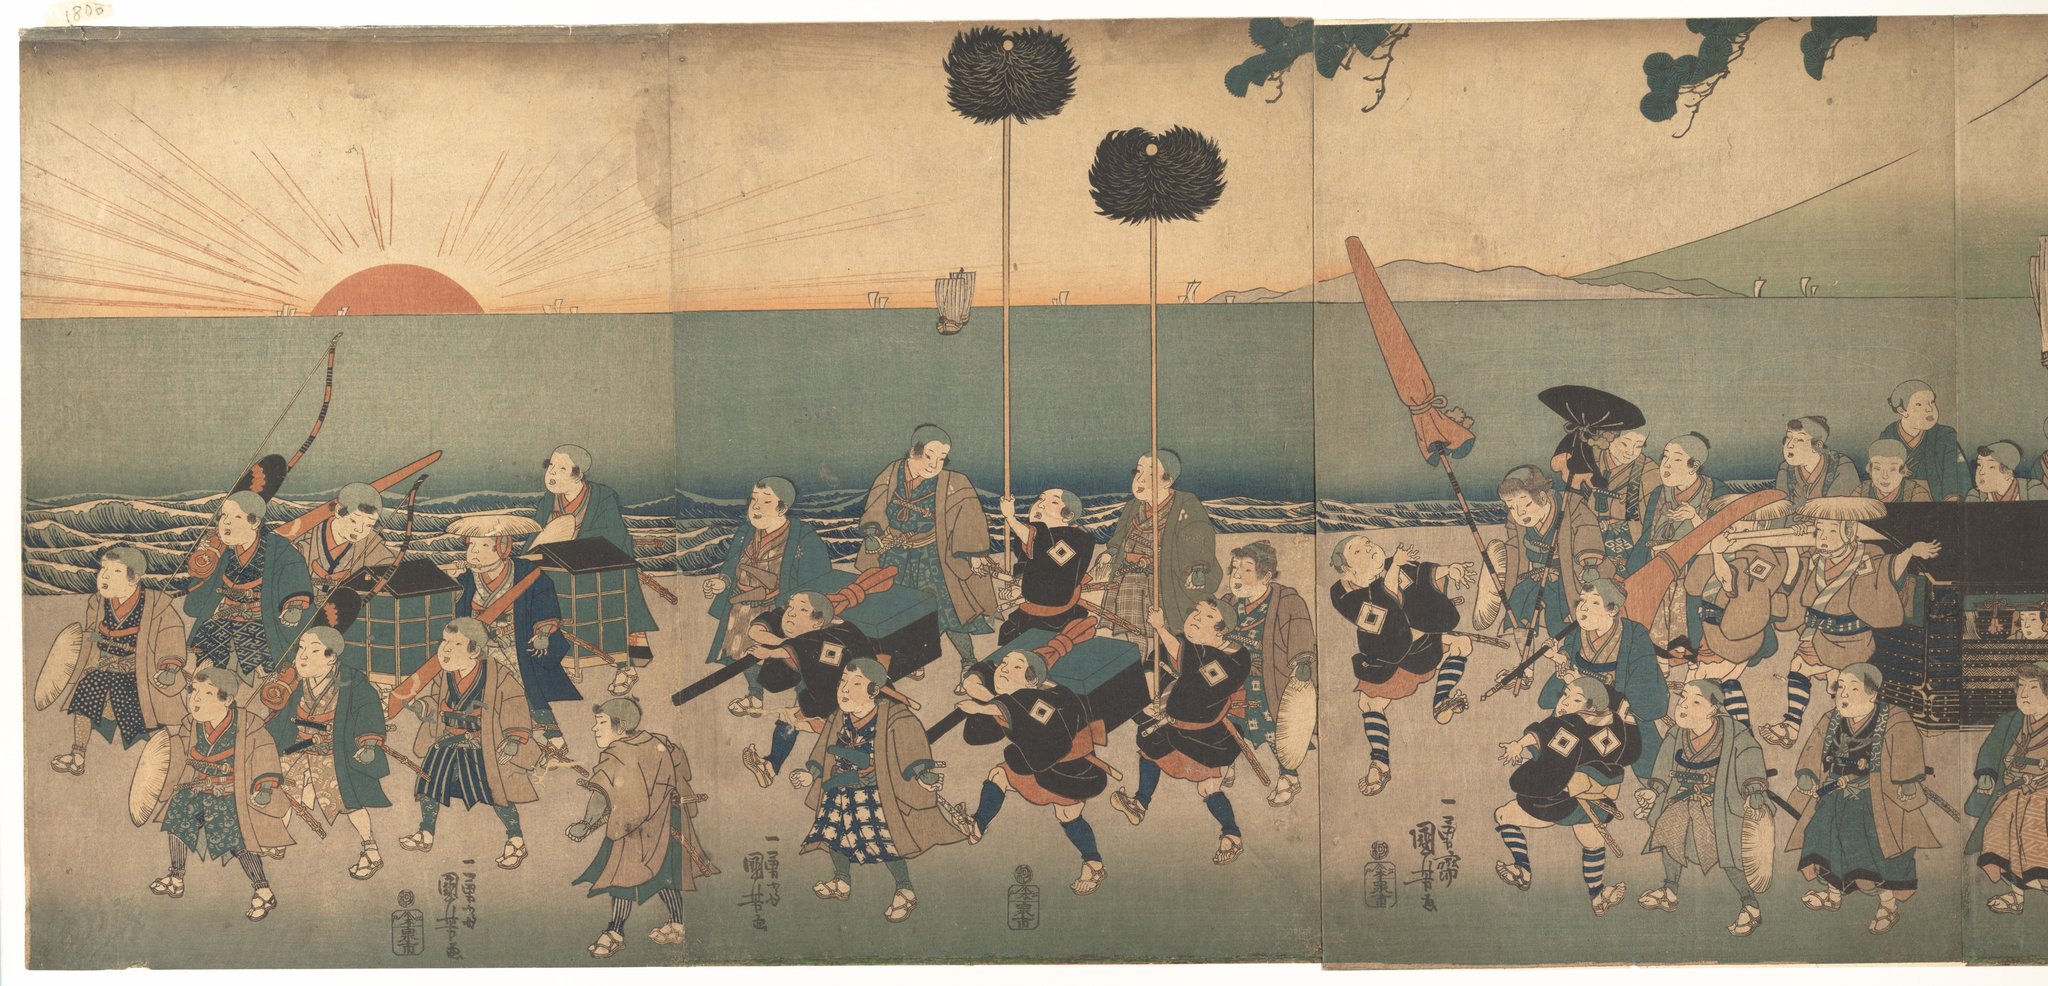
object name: print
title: Boys Play-acting a Daimyo Procession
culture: japanese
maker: utagawa kuniyoshi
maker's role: artist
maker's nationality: japanese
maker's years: 1797-1861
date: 1801-1900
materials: ink, paper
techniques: woodblock print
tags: boys,sun